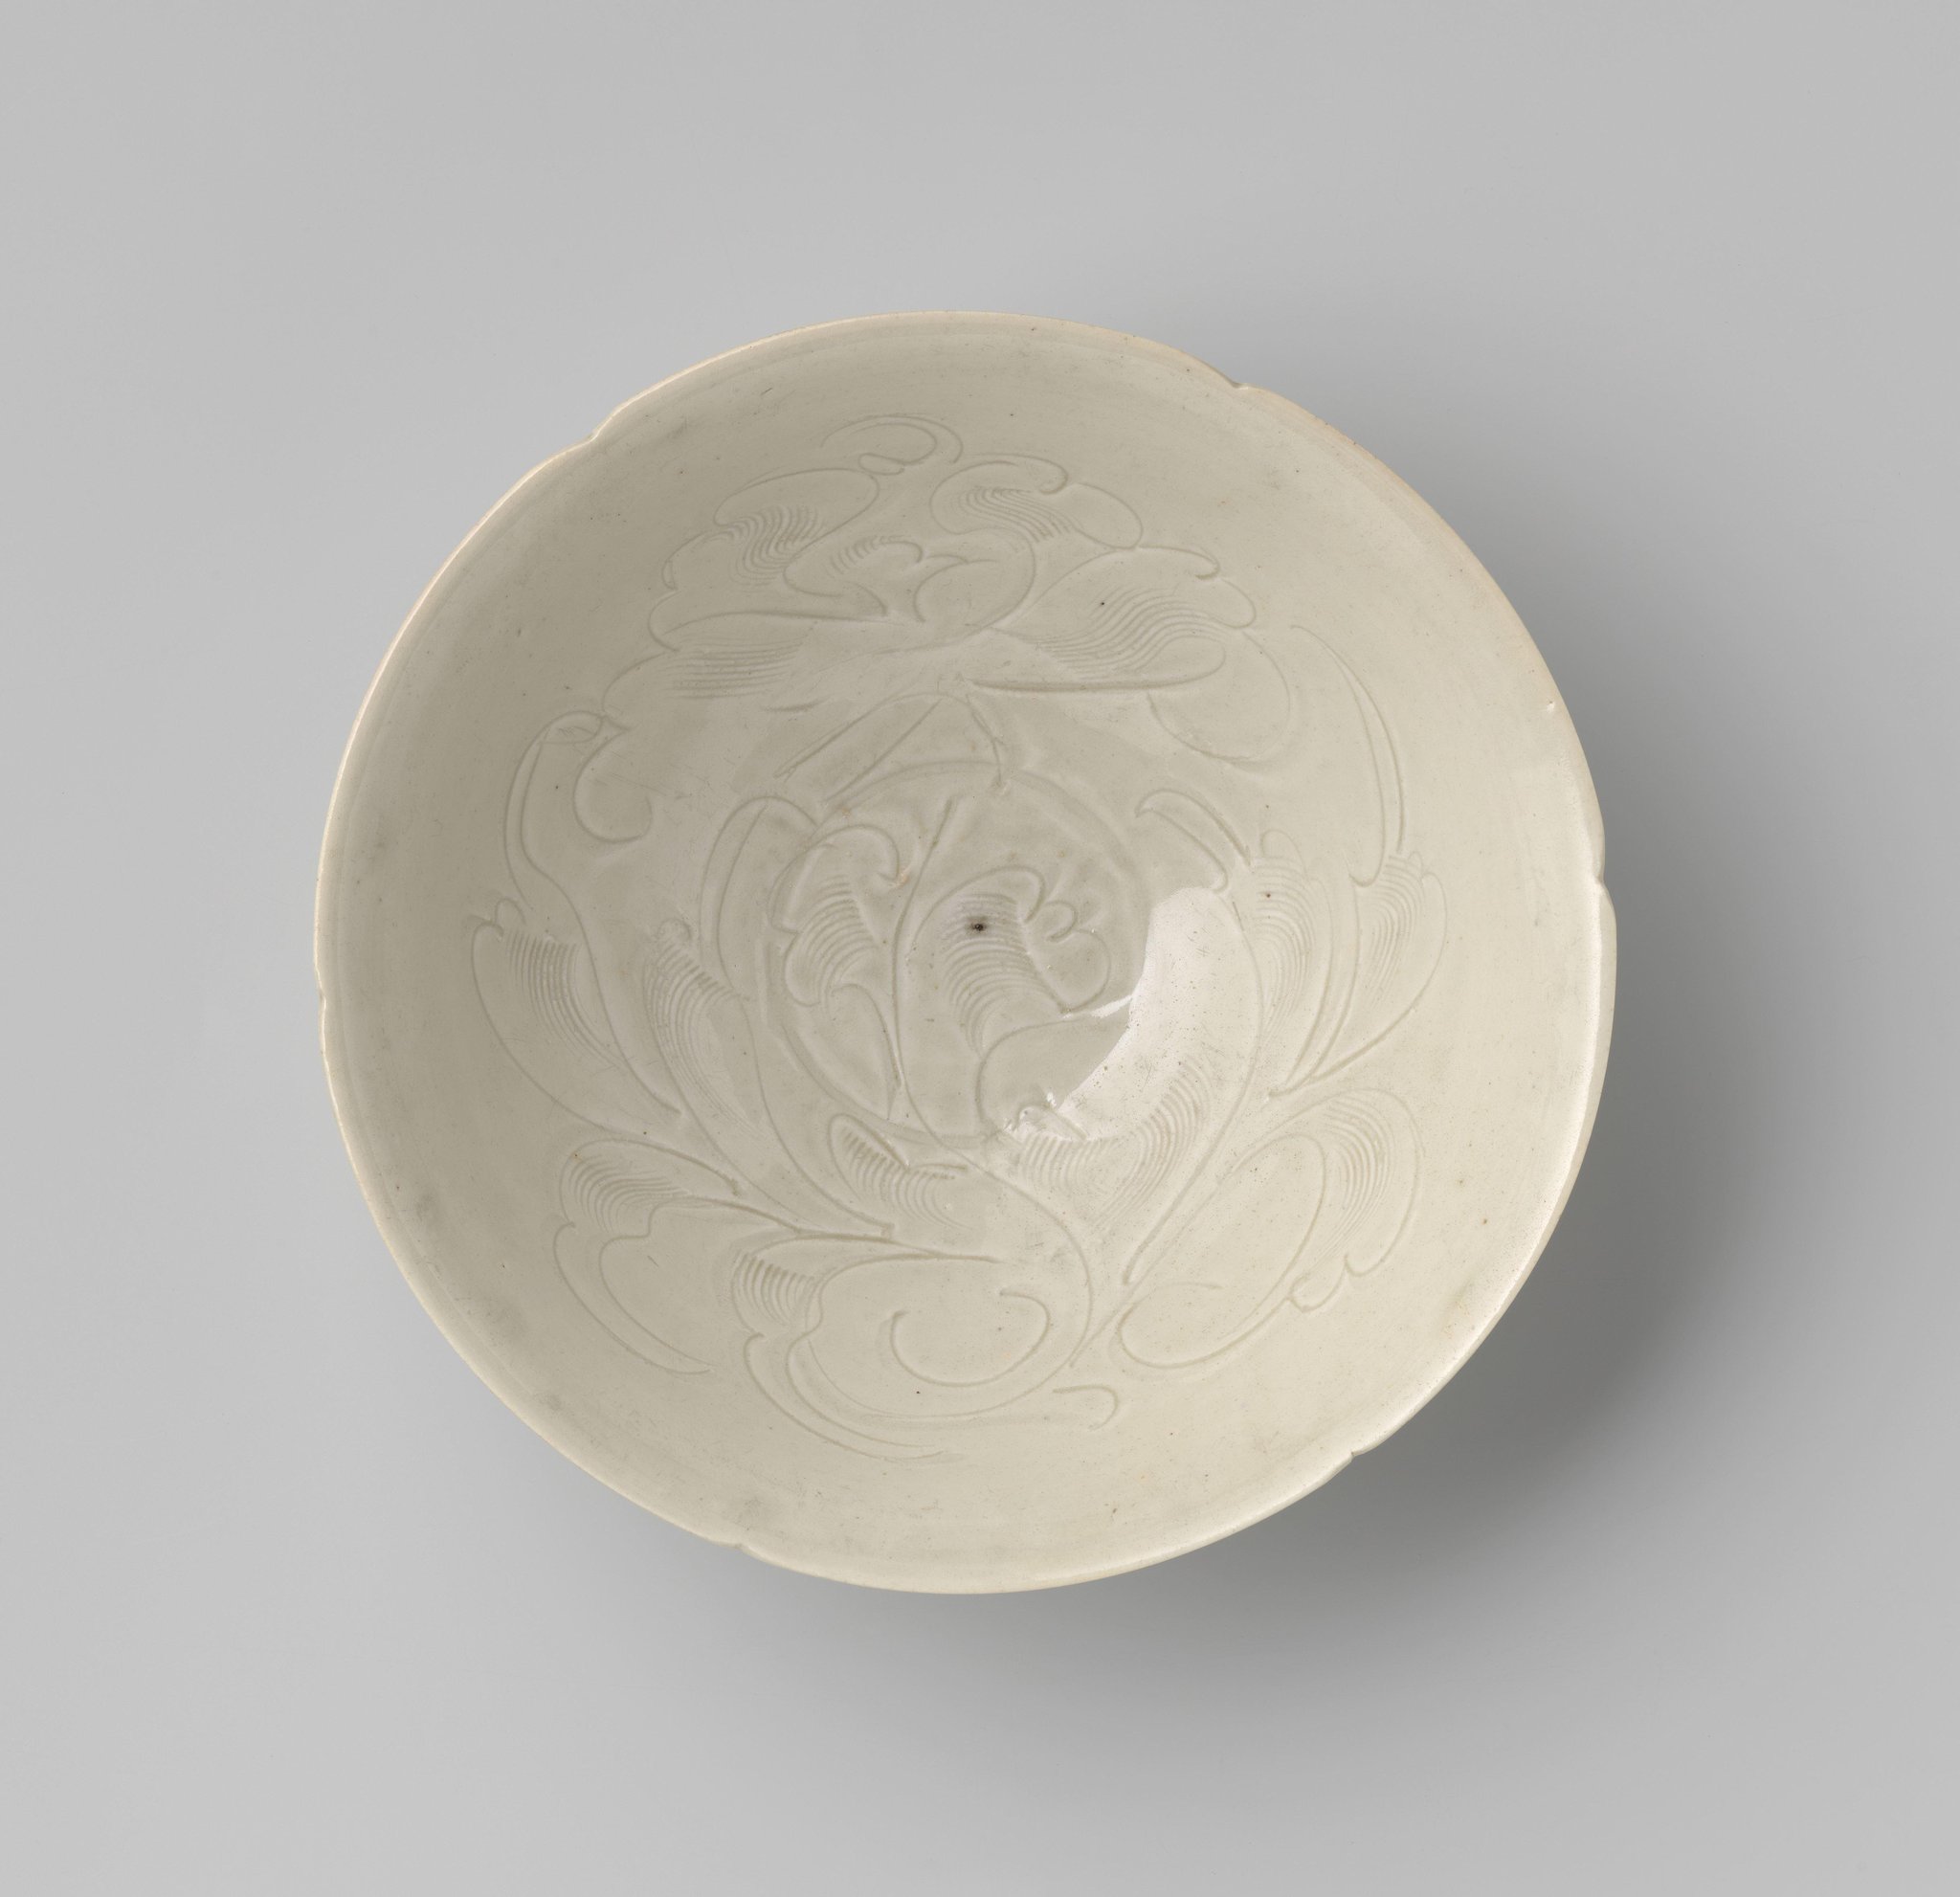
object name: bowl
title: Bowl with carved flower sprays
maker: Anonymous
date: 618-960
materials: ceramic, earthenware, stoneware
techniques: vitrification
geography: china